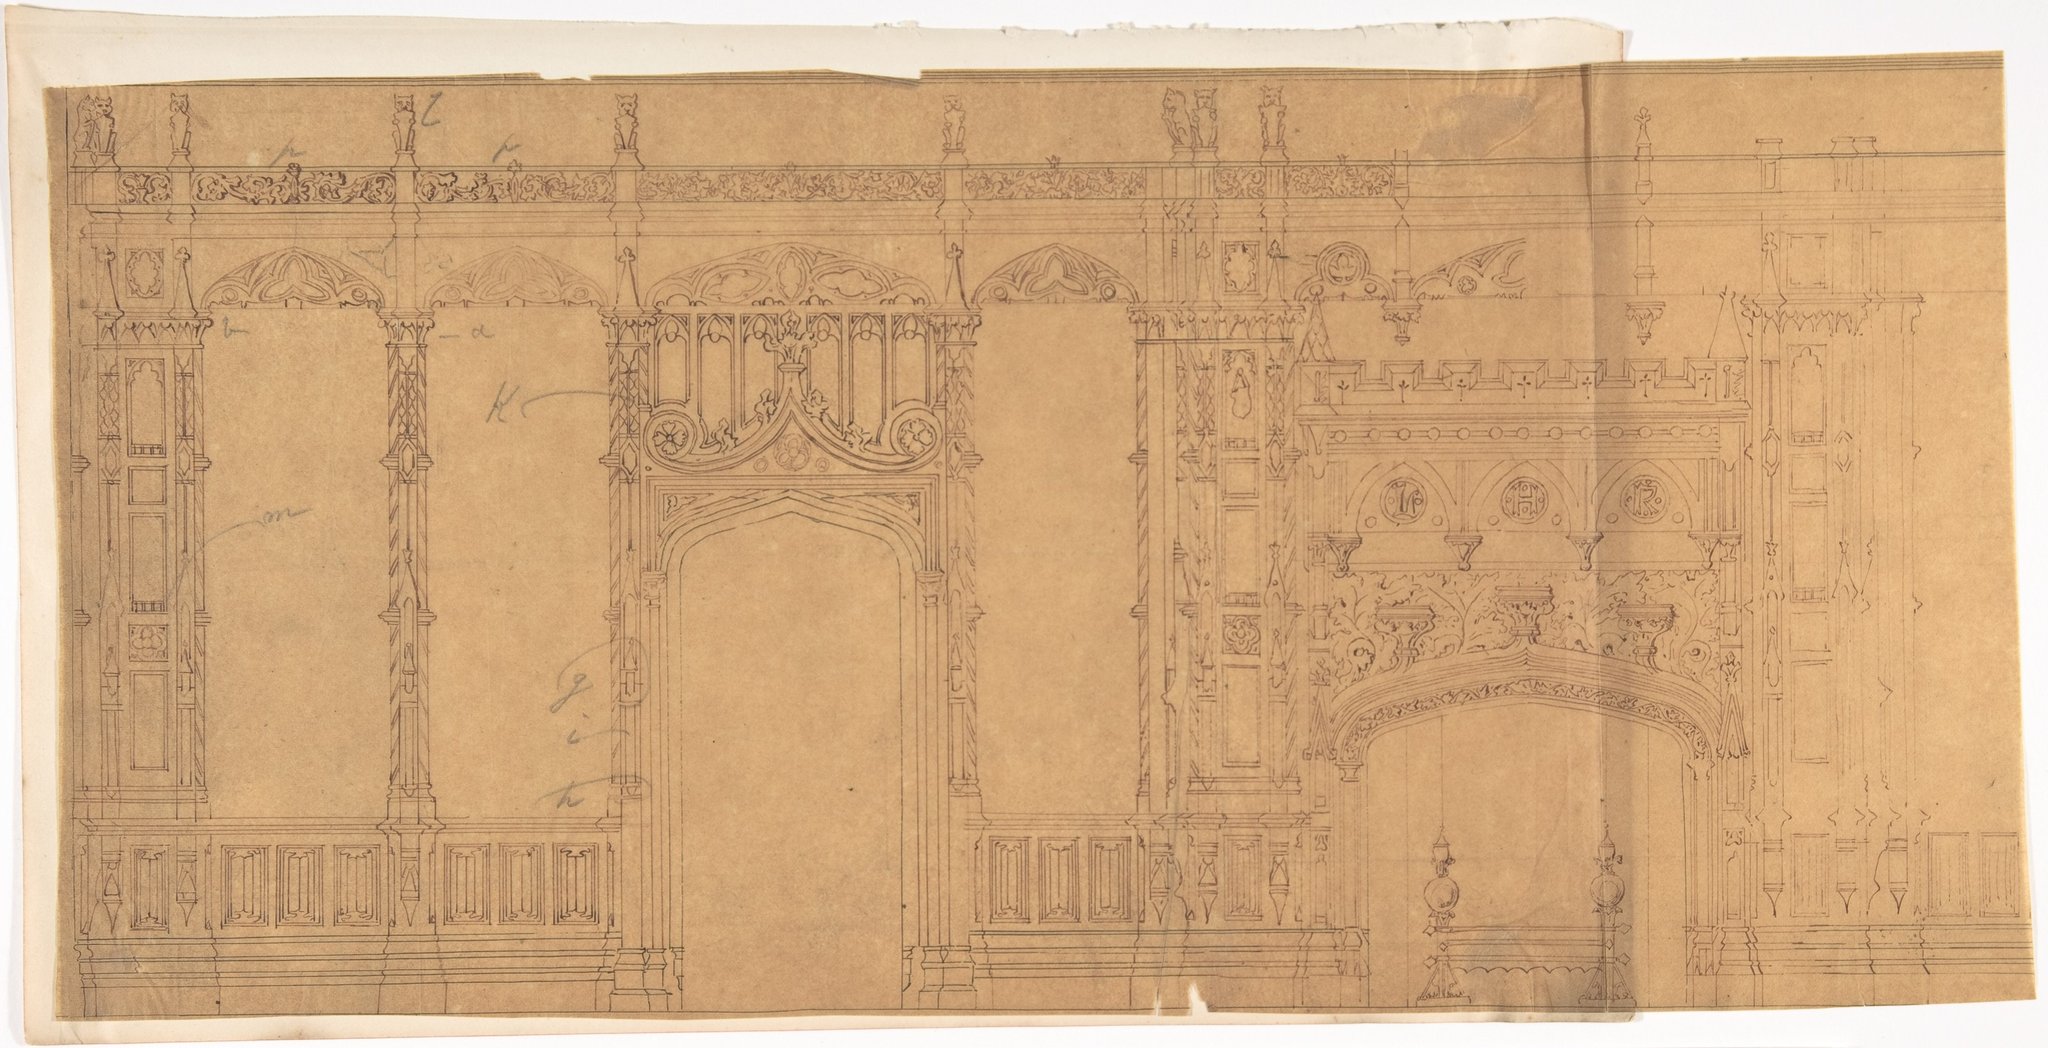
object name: drawing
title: Design for a Gothic Wall Containing a Door and Fireplace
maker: anonymous, british, 19th century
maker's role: artist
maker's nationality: british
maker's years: 1800-1900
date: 1801-1900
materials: ink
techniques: pen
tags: doors,fireplaces,ornament